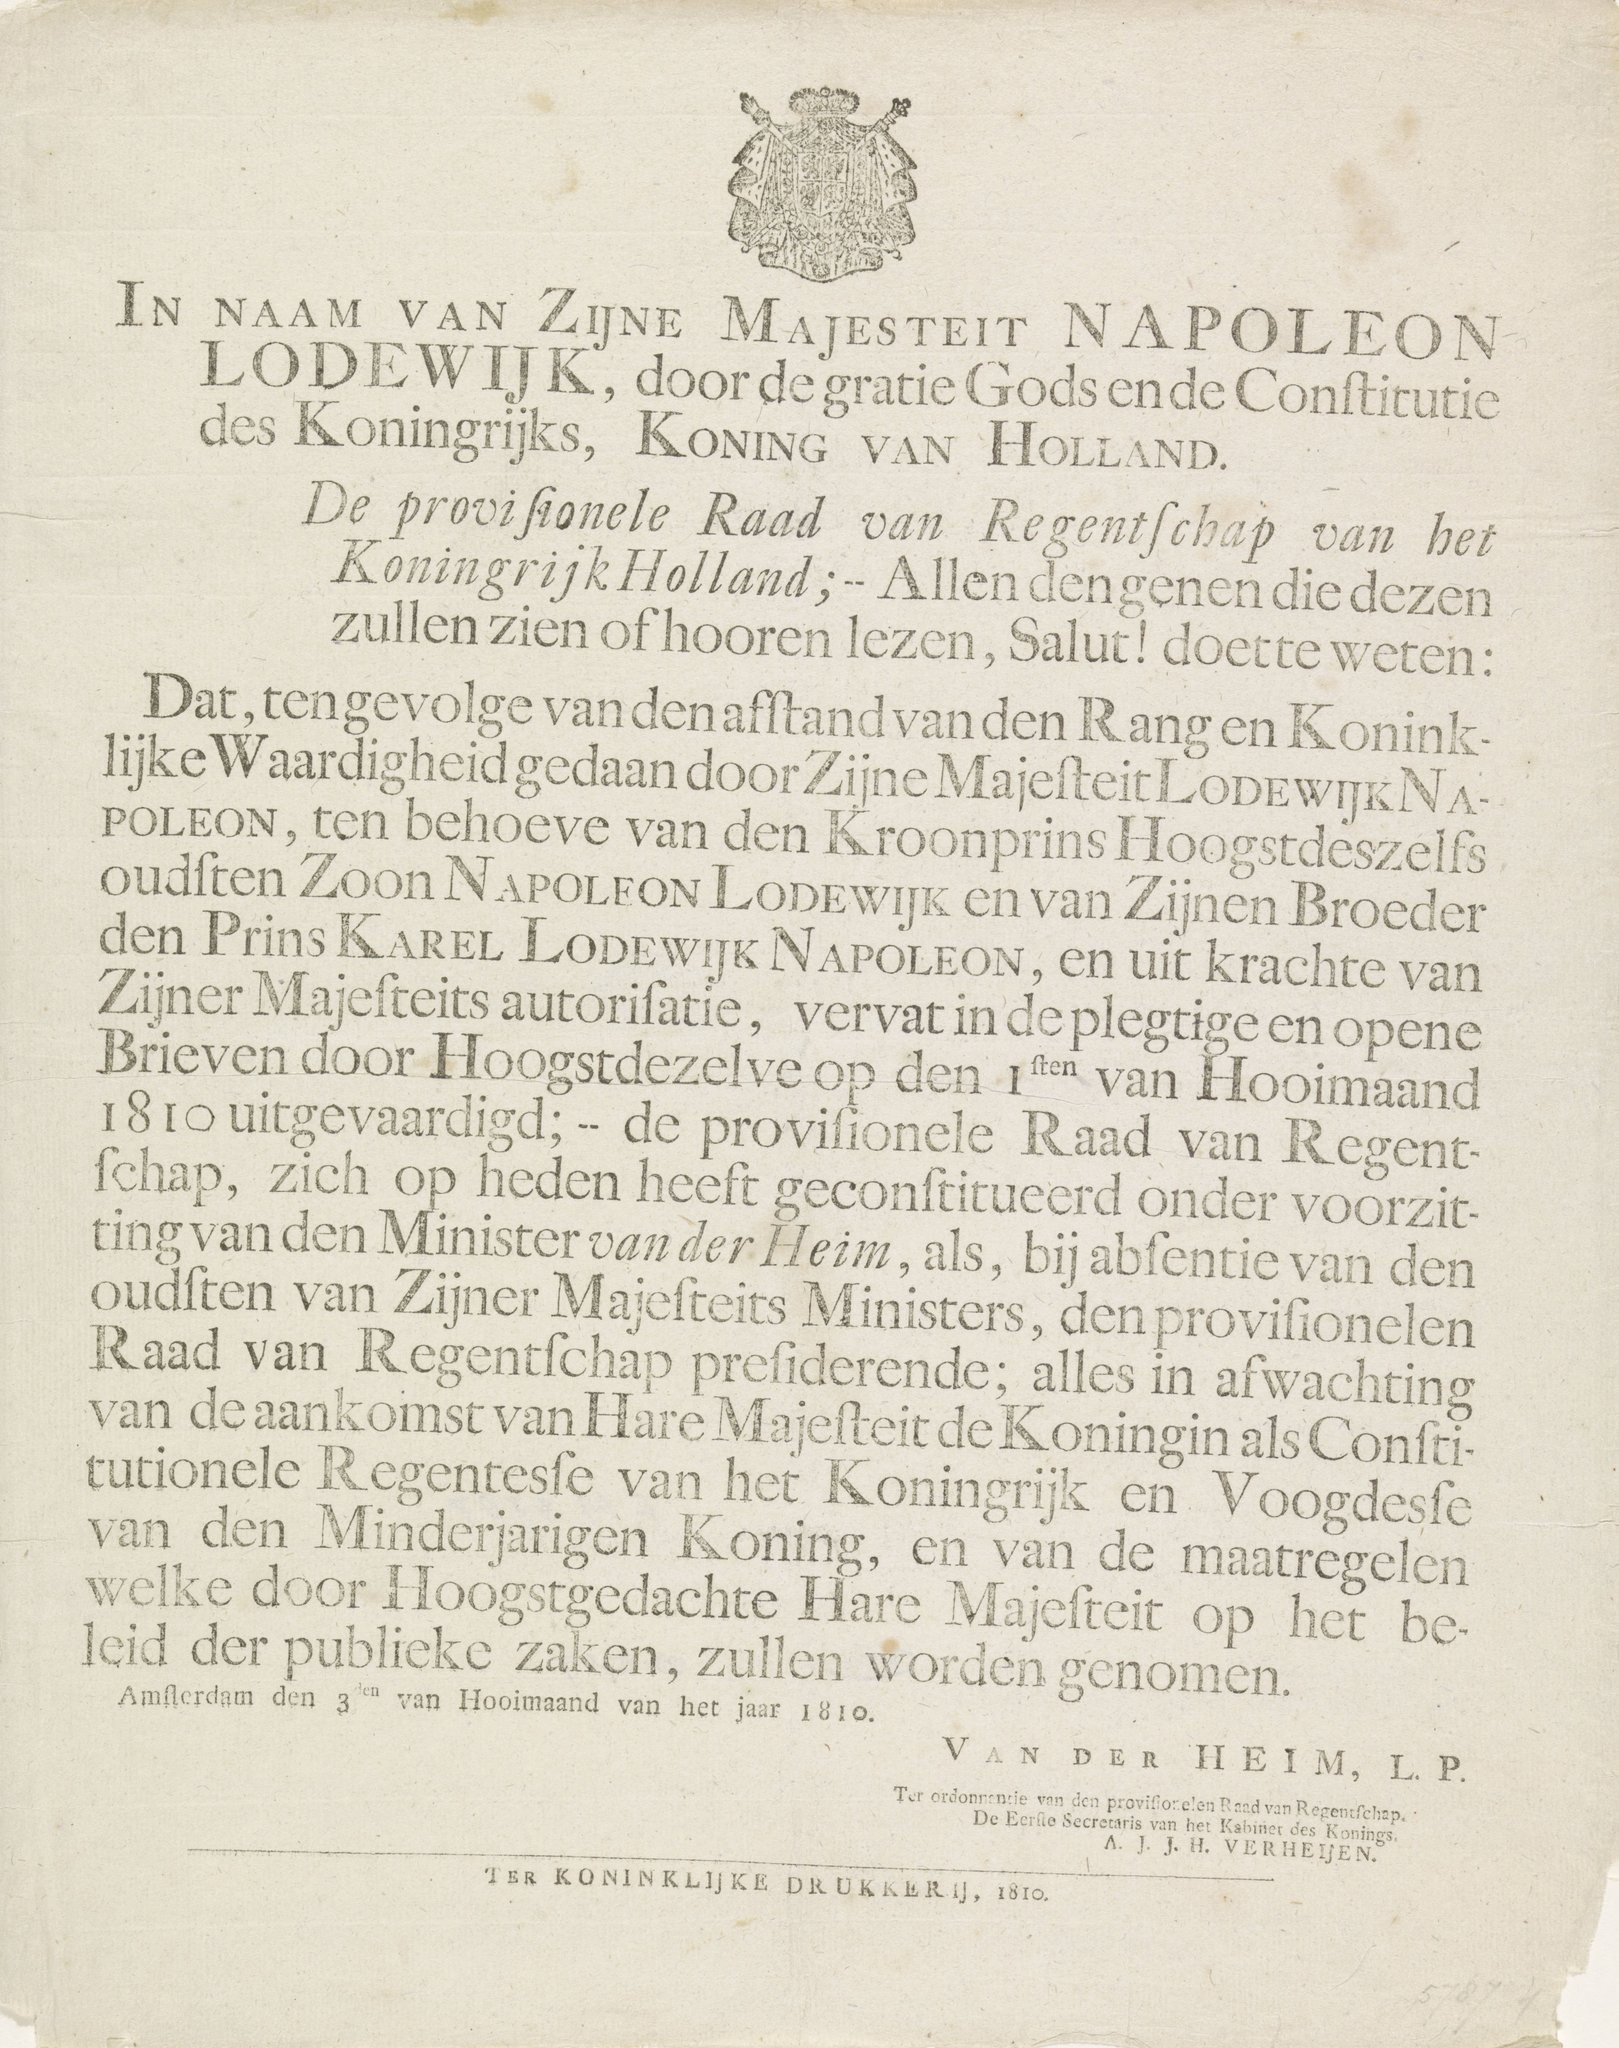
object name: text sheet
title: Publicatie van de provisionele Raad van Regentschap van het Koninkrijk Holland, 1810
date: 1807-1810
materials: paper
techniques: letterpress printing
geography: netherlands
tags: louis napoleon (king of holland), paris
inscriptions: collector's mark: Lugt 2228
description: Publicatie van 3 juli 1810 van de oprichting van de provisionele Raad van Regentschap, in afwachting van de komst van de koningin als regentesse van de minderjarige Napoleon Lodewijk, aan wie koning Lodewijk Napoleon op 1 juli 1810 troonsafstand heeft gedaan. Tekst in twee kolommen, bovenaan het koninklijk wapen.